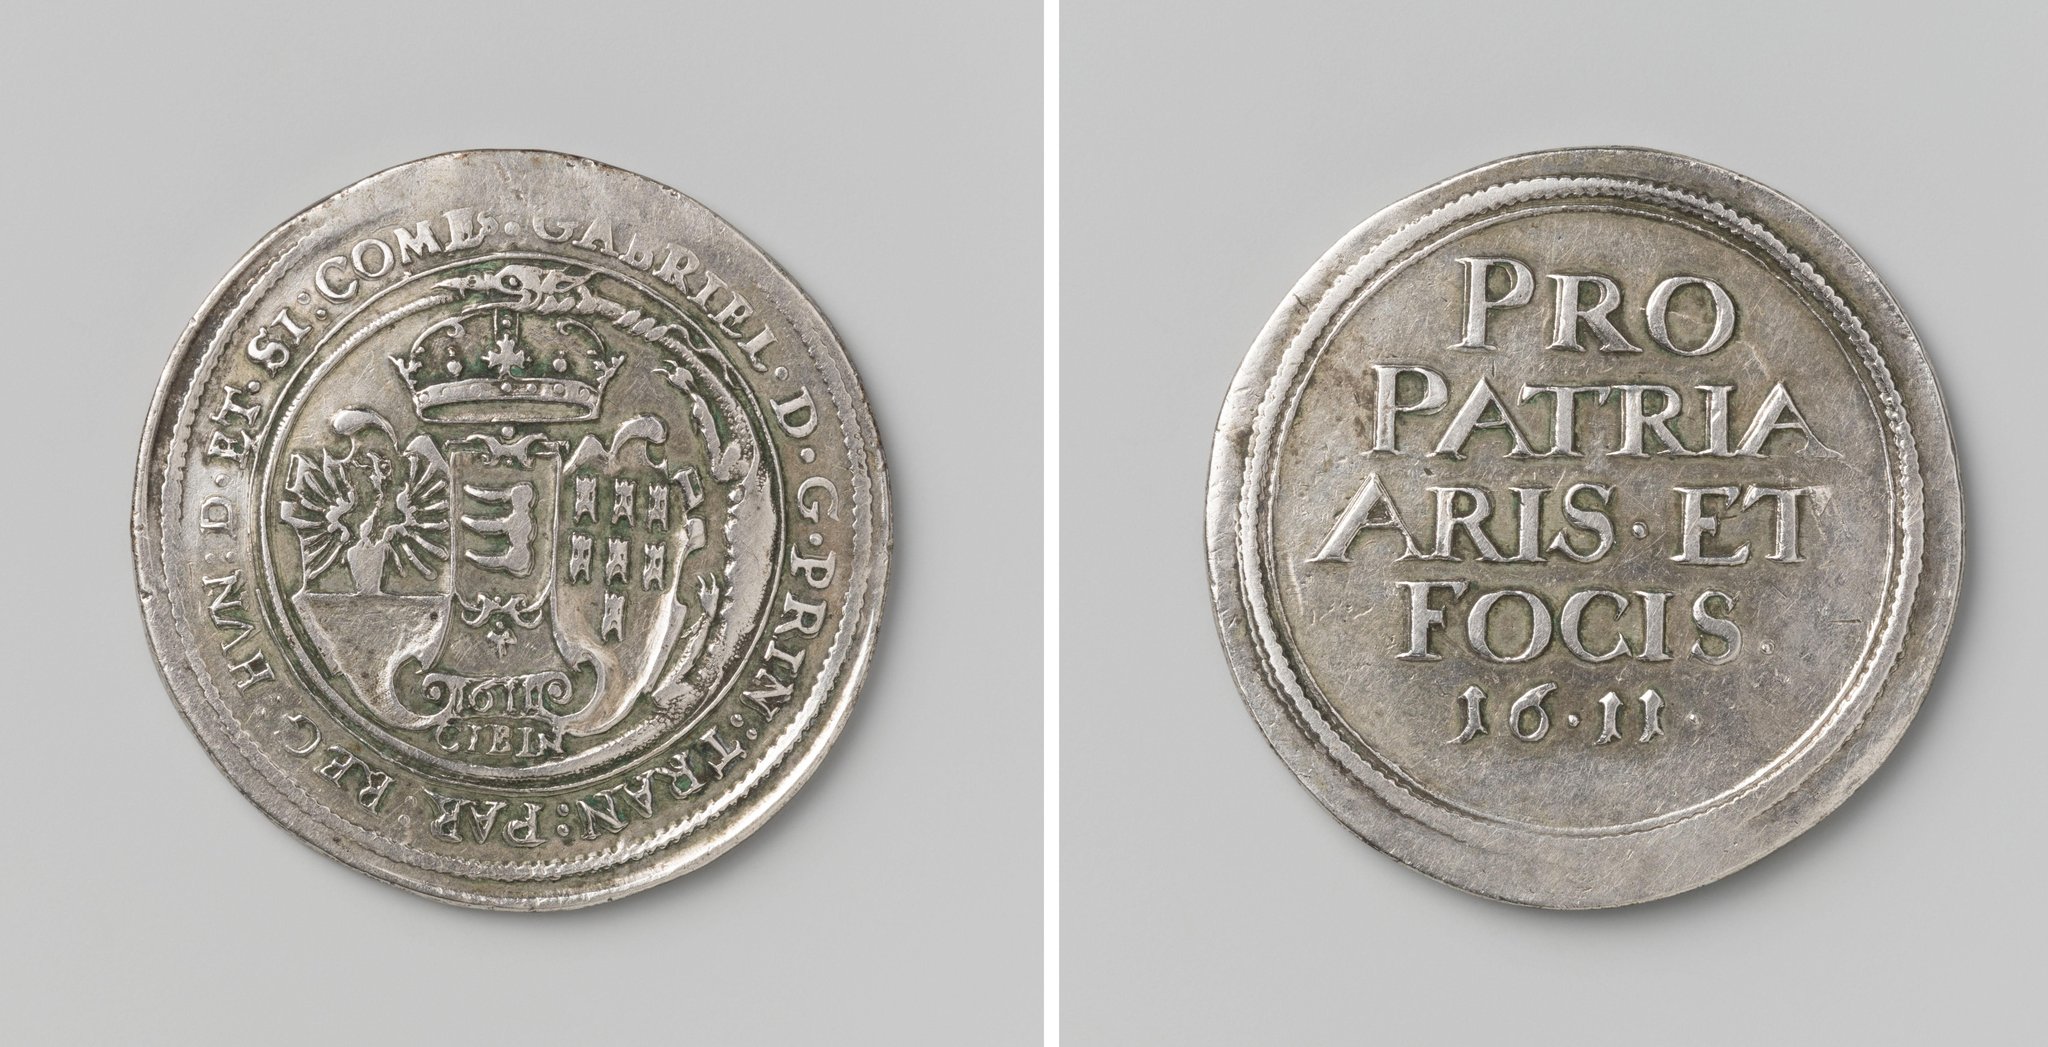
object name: siege coin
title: taler, noodmunt uit Hermannstadt, geslagen tijdens het beleg, door Gabriel Bathory, koning van Transsylvanië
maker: Anonymous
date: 1611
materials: silver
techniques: striking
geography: hermannstadt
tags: koning, gabriel bathory (koning van transsylvanië), hermannstadt, oorlog van turken tegen heilige roomse rijk, beleg van hermannstadt (1611)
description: Voorzijde: gekroond wapenschild boven jaartal en letters CIBIN binnen slangerond en omschrift. Keerzijde: opschrift